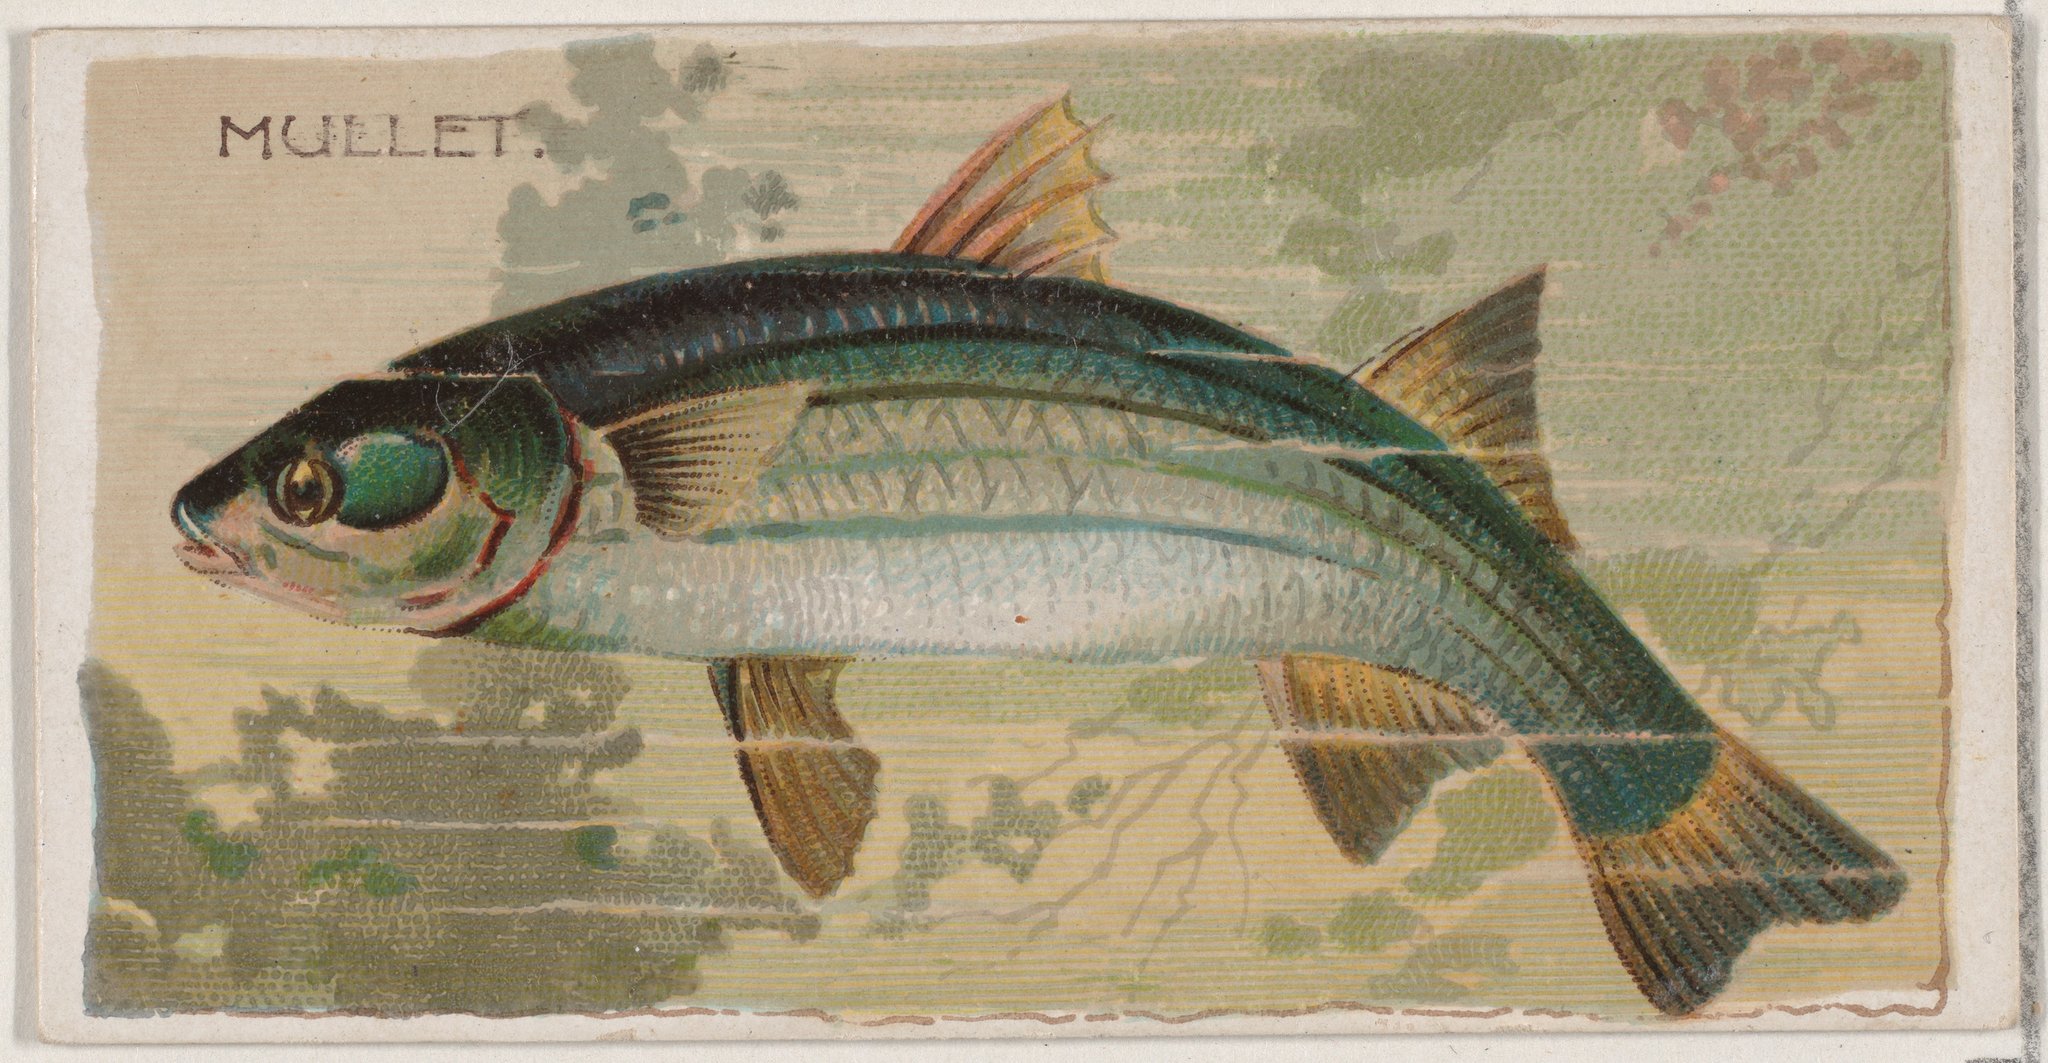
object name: print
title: Mullet, from the series Fishers and Fish (N74) for Duke brand cigarettes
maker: knapp & company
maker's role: lithographer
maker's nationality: american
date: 1888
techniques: color lithograph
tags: fish